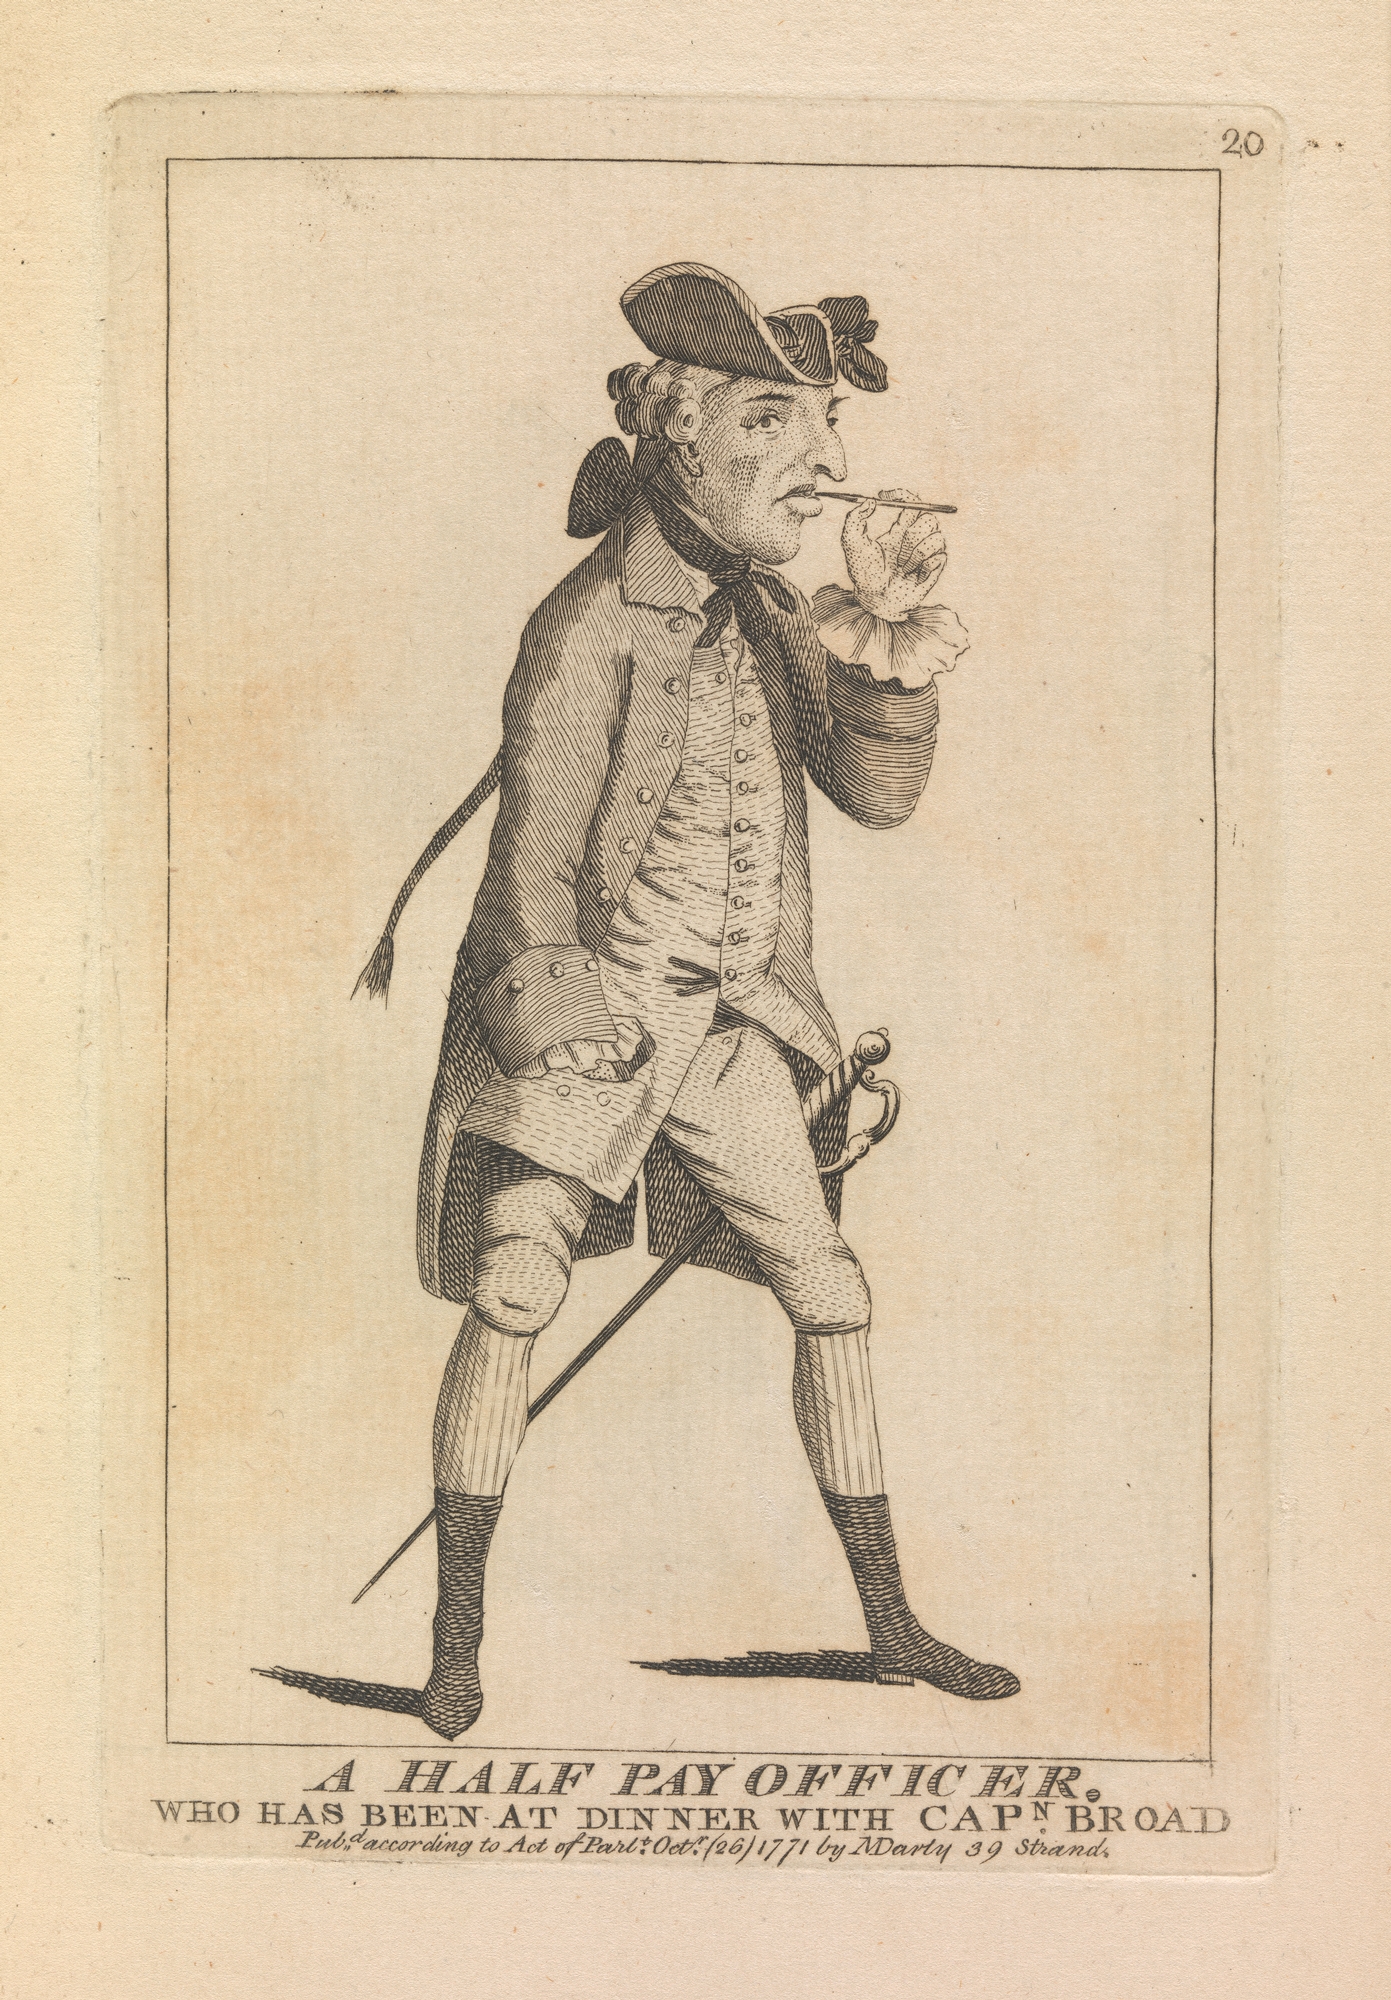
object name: print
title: A Half Pay Officer Who Has Been at Dinner with Captain Broad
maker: matthias darly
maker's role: publisher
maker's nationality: british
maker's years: 1720-1780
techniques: etching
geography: london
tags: soldiers,men,smoking